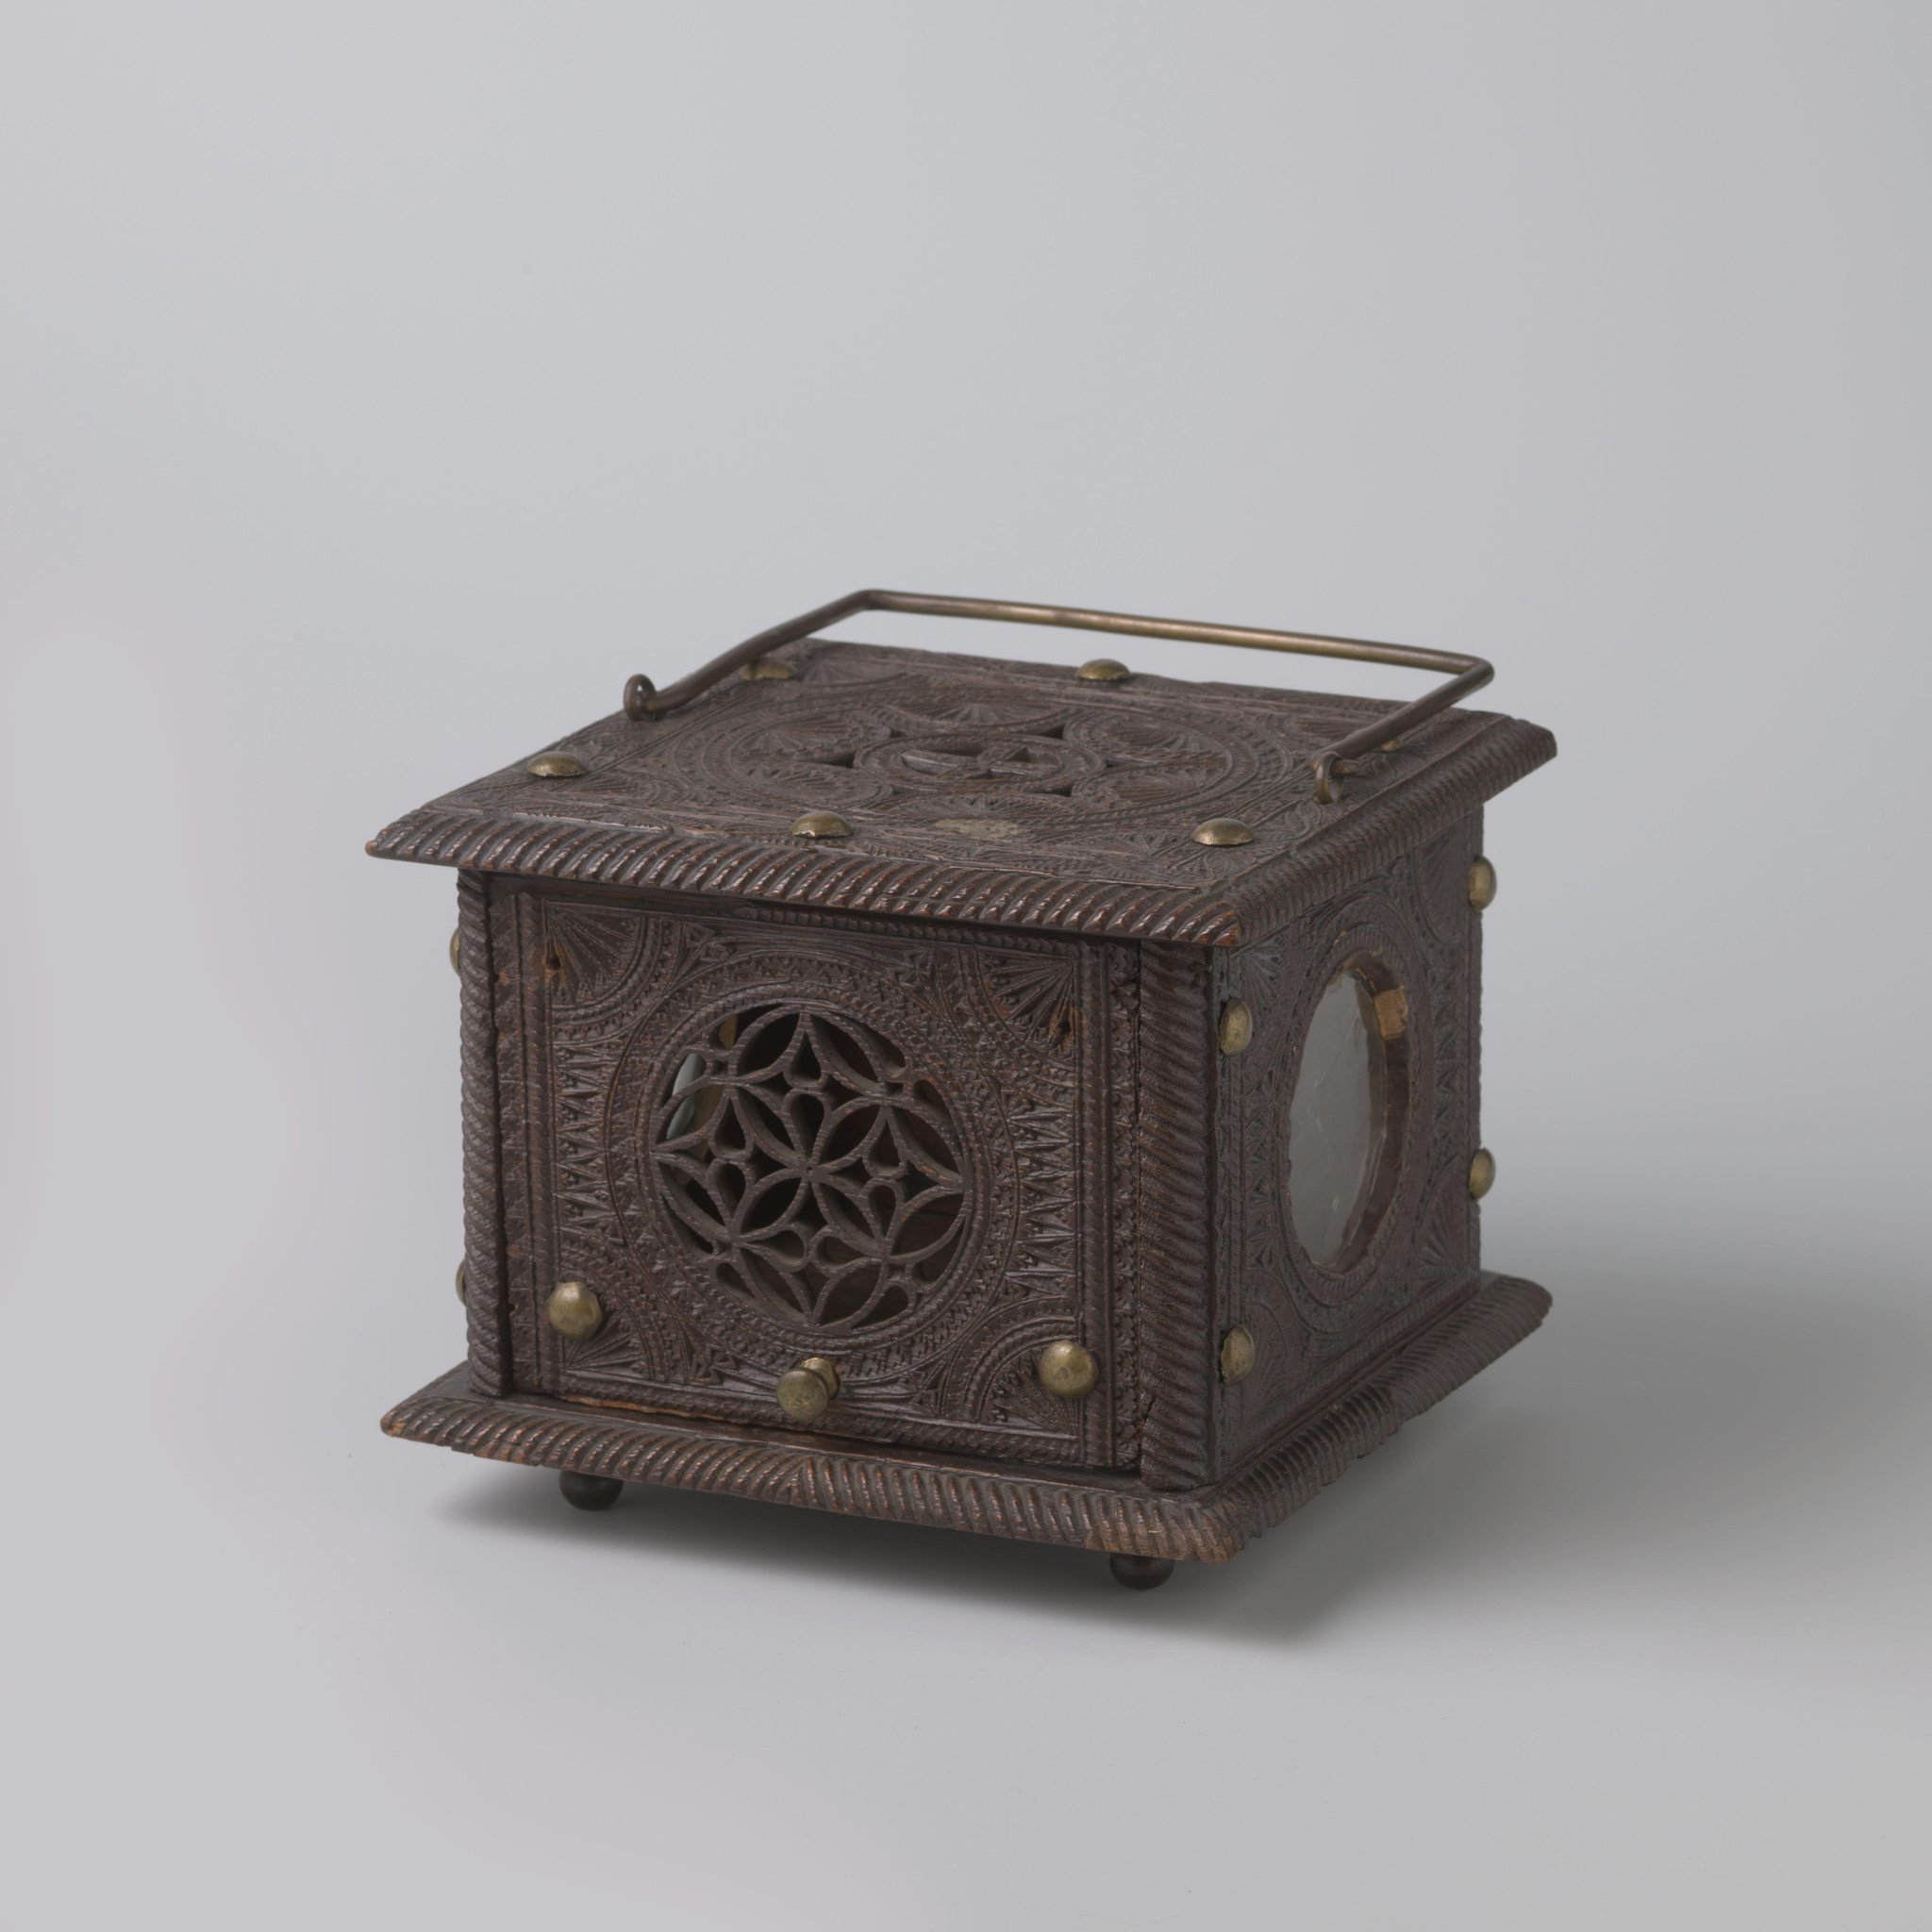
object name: furniture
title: Stoof met twee medaillons van glas waarvan één is beschilderd met drie vrouwenfiguren die aan een maaltijd zitten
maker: Anonymous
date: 1400-1950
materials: copper, glass, wood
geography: northern netherlands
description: Eikenhouten stoof op poten, met een koperen hengsel en versierd met koperen knopen. In twee der zijwanden zijn in de medaillons glaasjes gezet, waarvan één glaasje beschilderd is met drie vrouwefiguren, gezeten aan een maaltijd (dit glaasje is gebarsten in vier stukken).